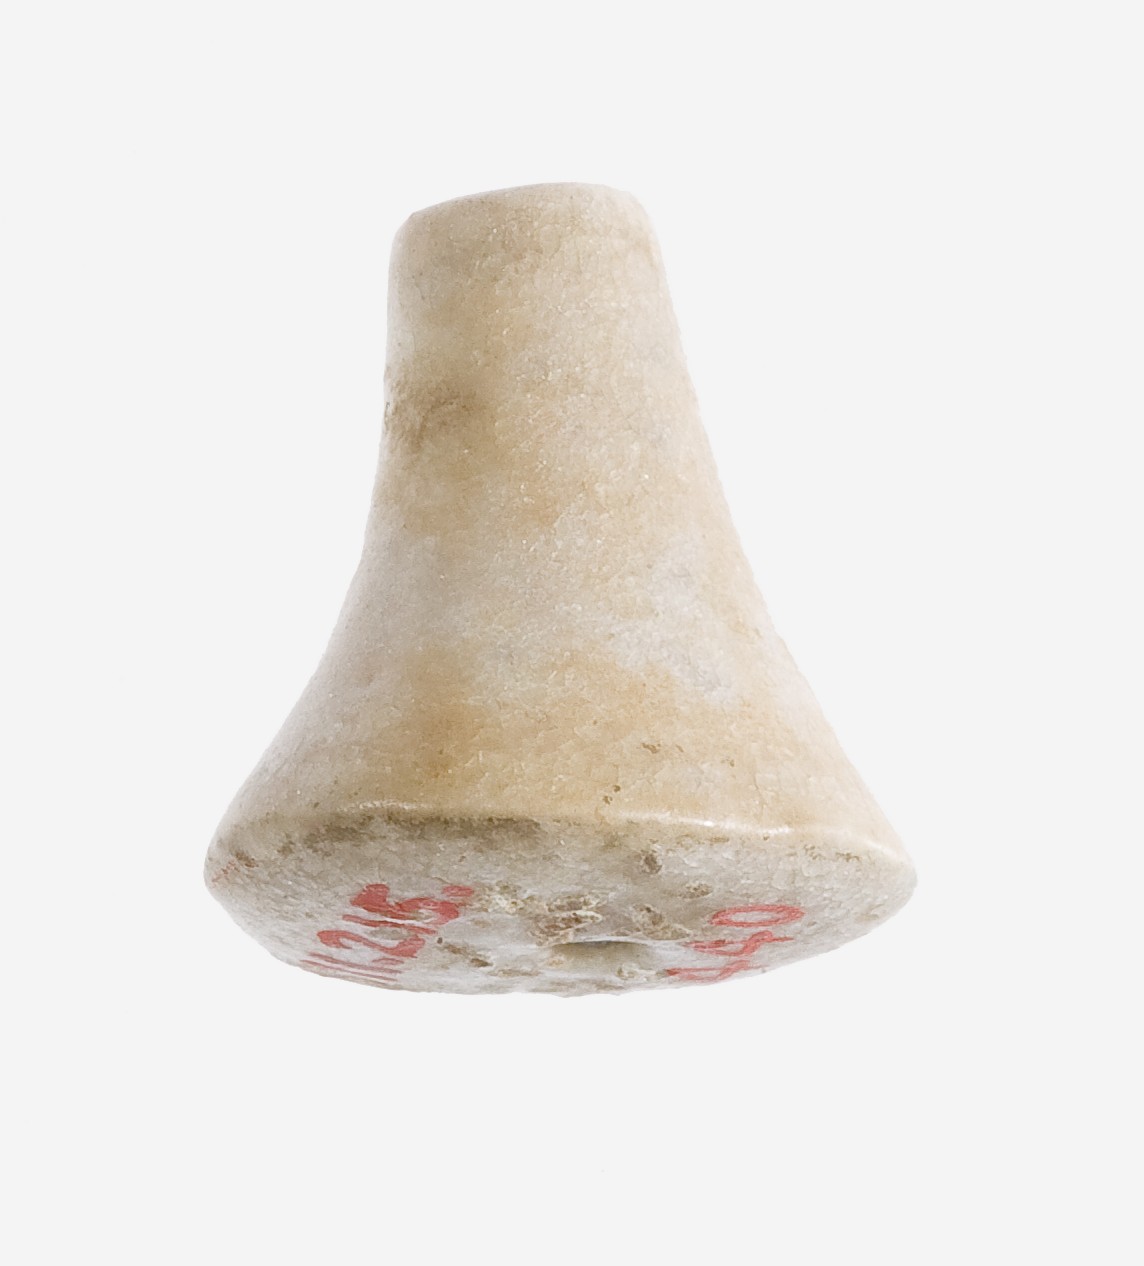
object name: pendant, umbel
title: Umbel Pendant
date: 1390-1352 BCE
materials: faience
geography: egypt